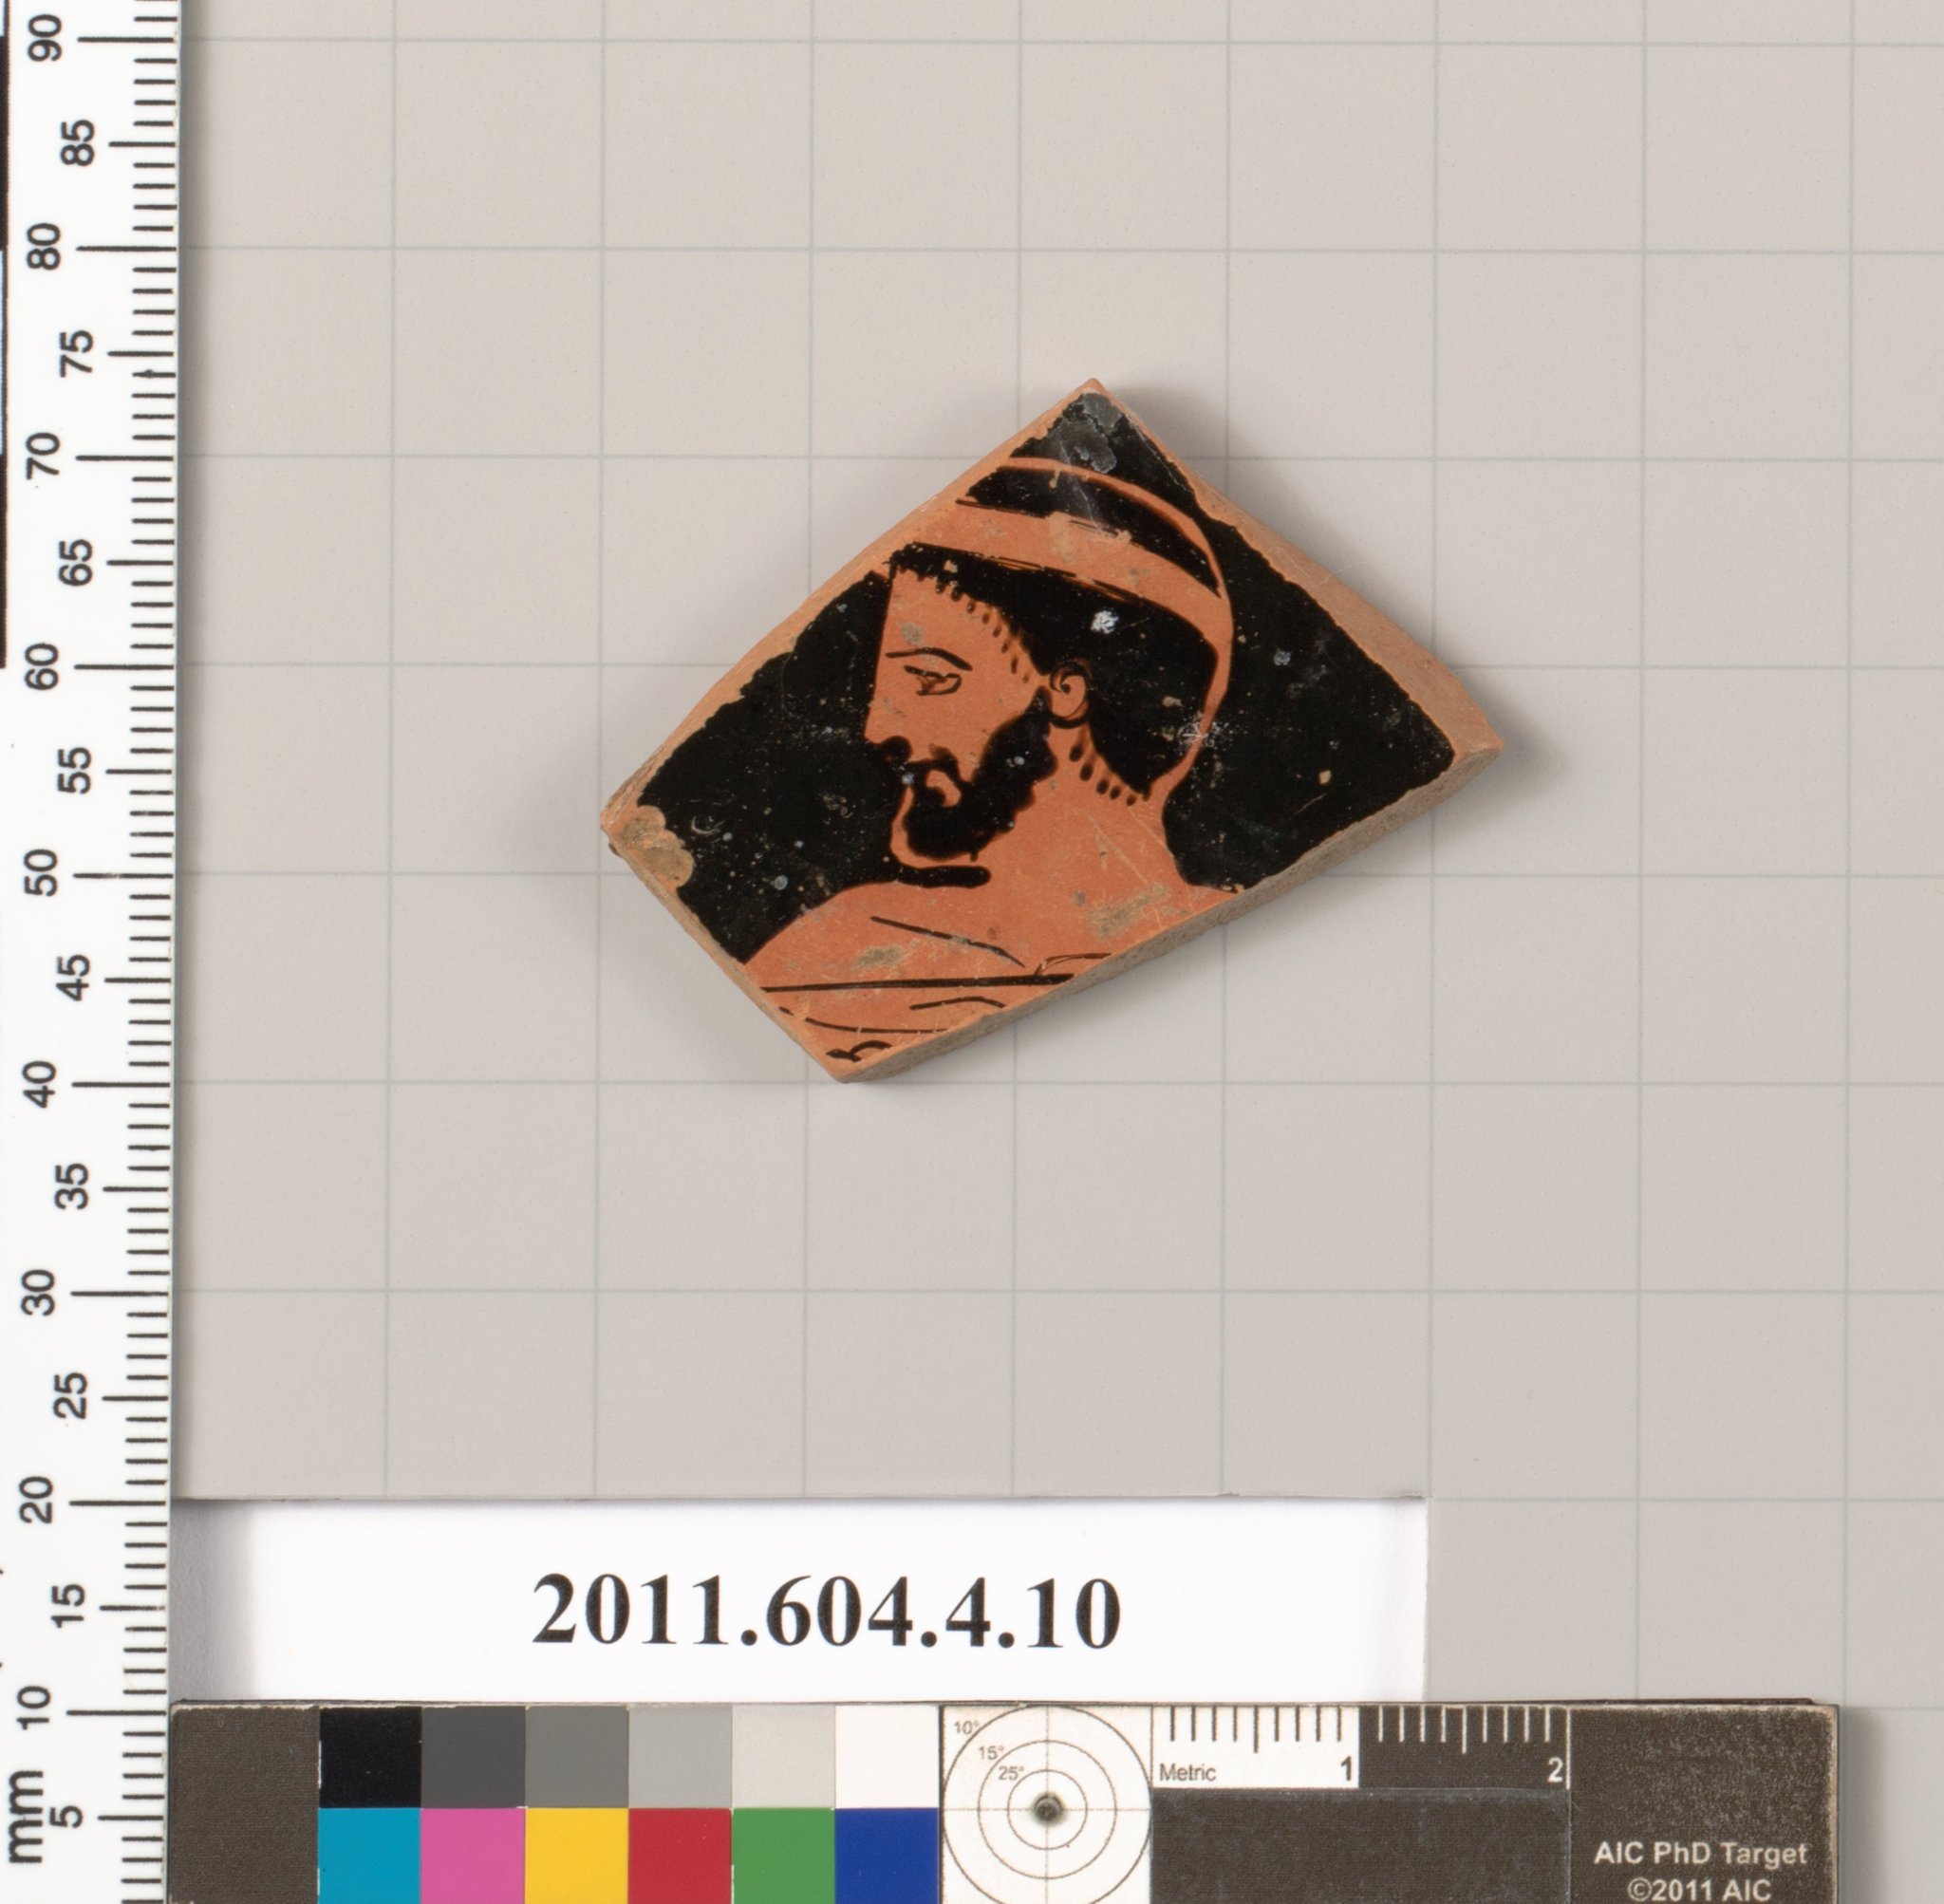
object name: kylix fragment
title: Terracotta fragment of a kylix (drinking cup)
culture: greek, attic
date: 467-435 BCE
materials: terracotta